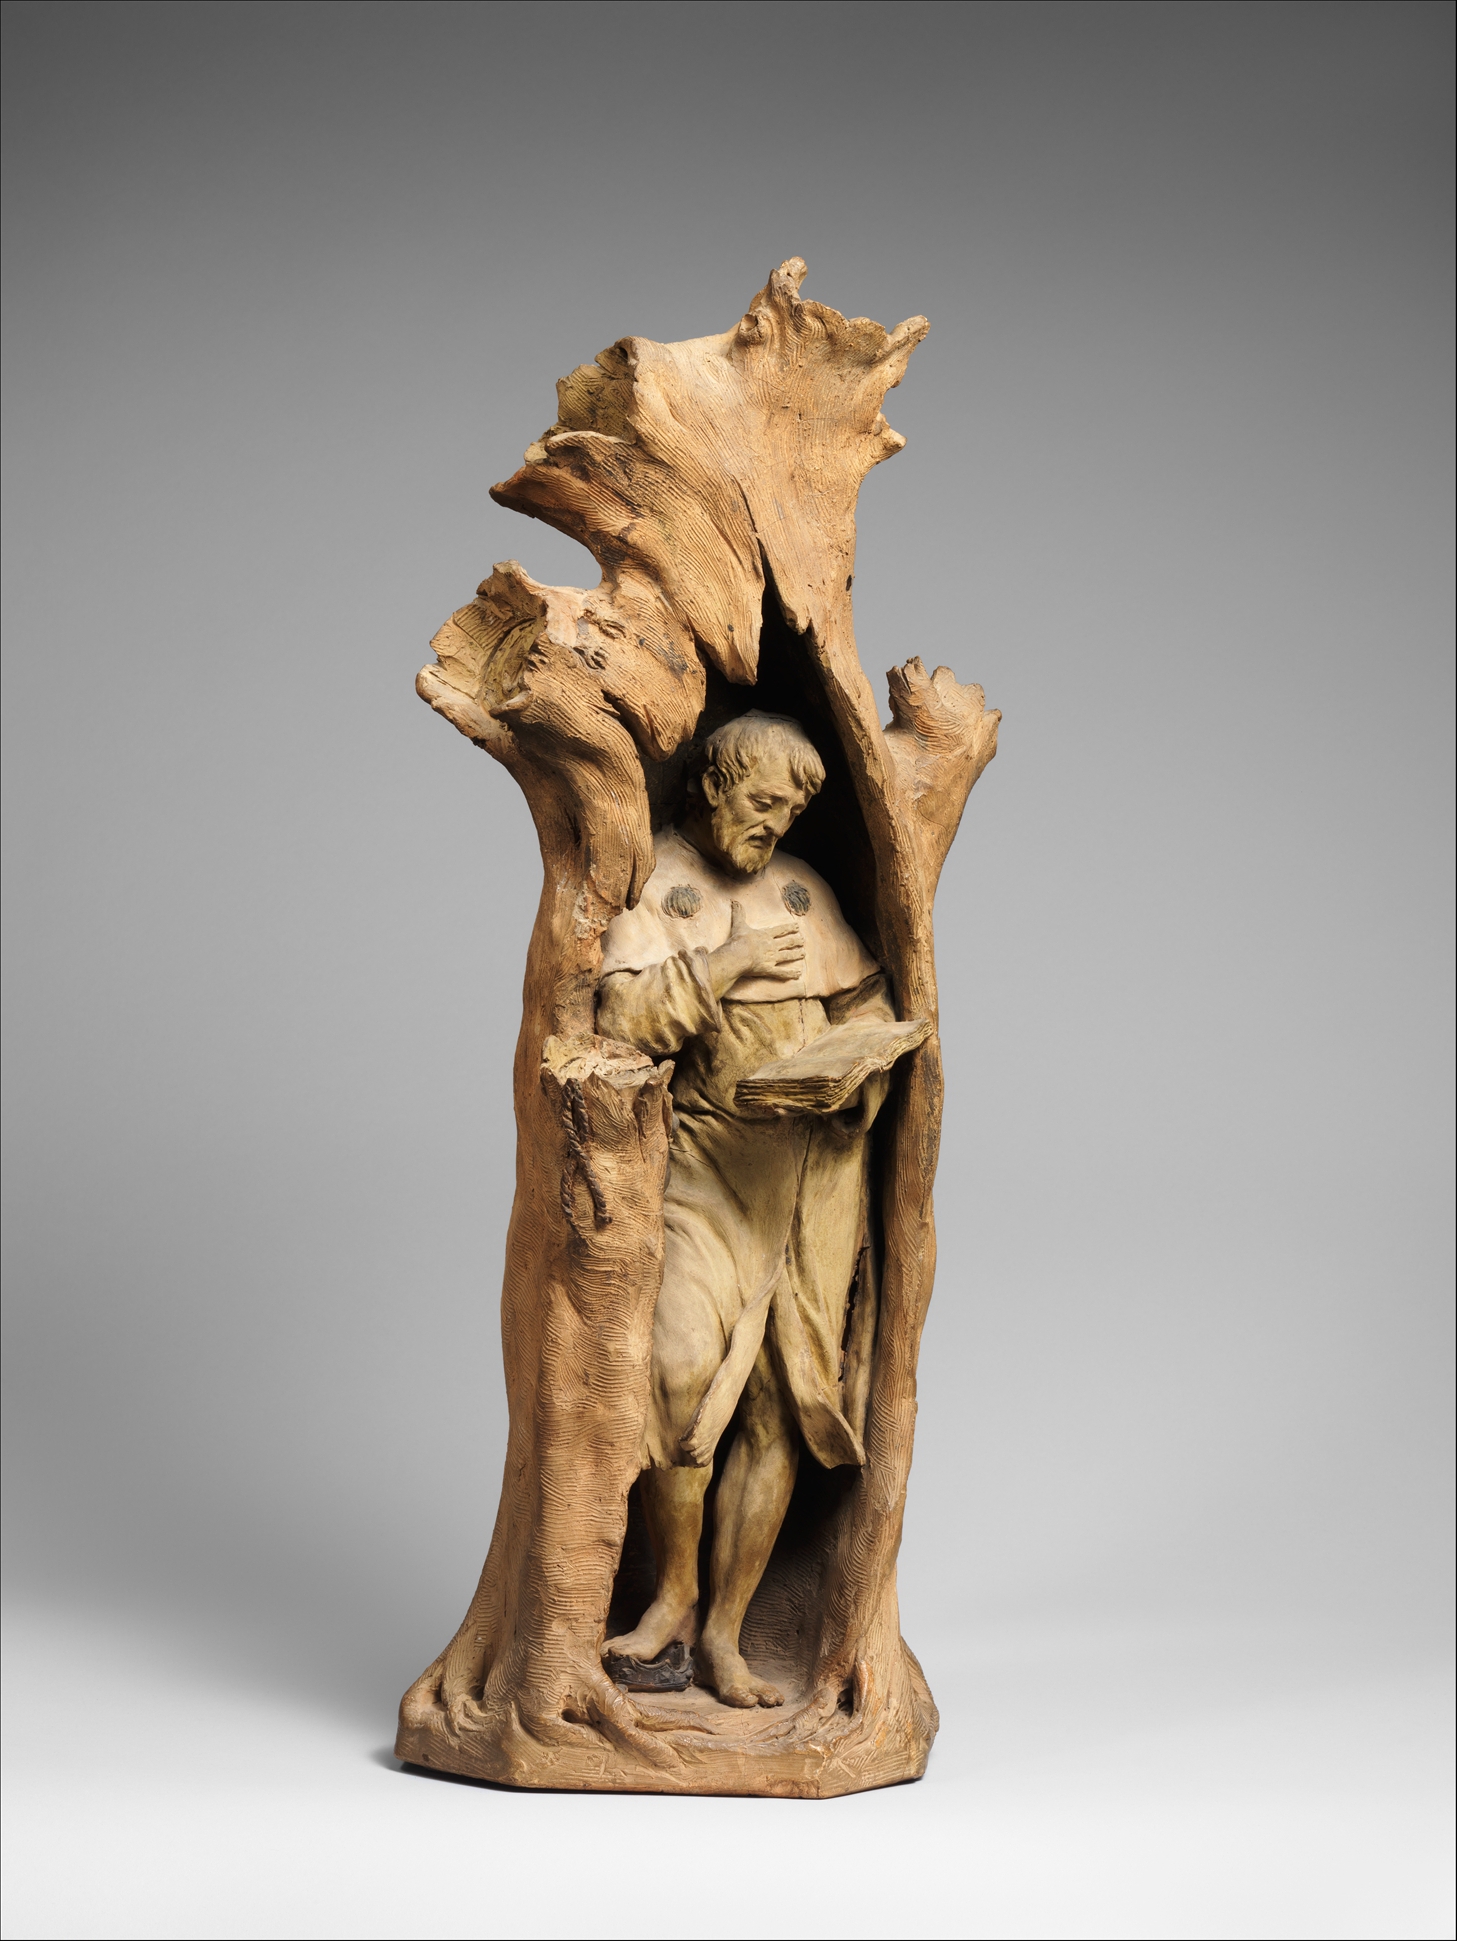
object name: statuette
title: Holy Roman Emperor Henry IV at Canossa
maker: ubaldo gandolfi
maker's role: maker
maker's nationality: italian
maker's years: 1728-1781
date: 1770-1775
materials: terracotta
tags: kings,reading